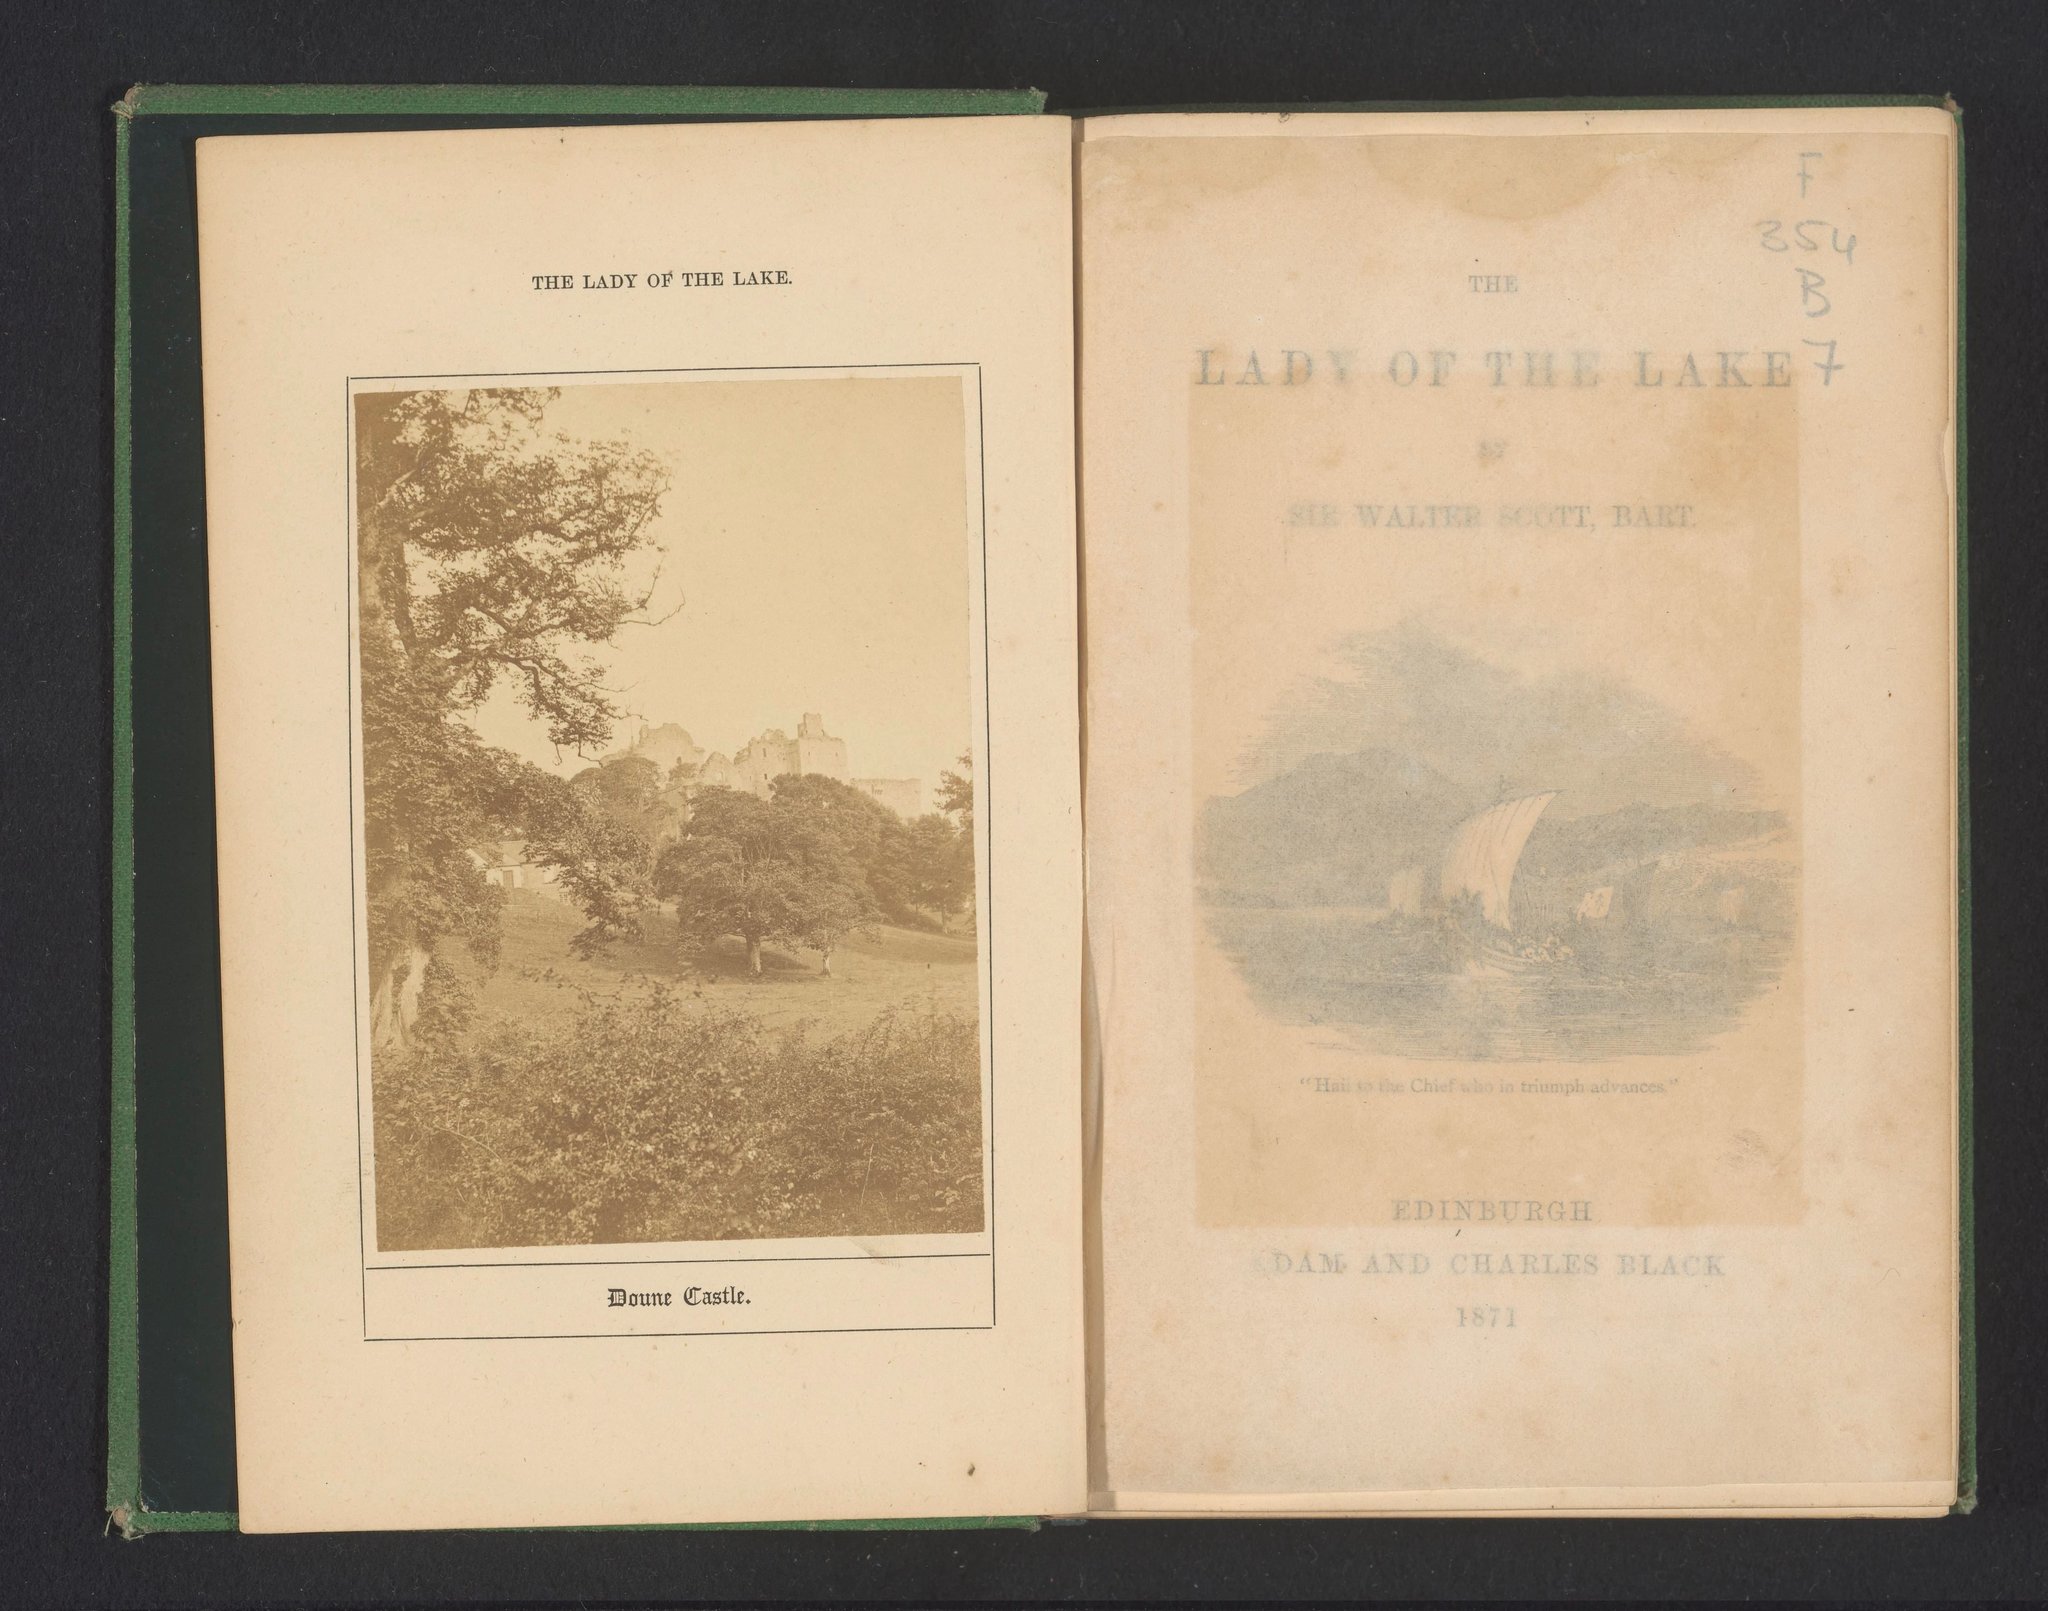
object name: photograph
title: Gezicht op Doune Castle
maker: george washington wilson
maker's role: publisher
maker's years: 1823-1893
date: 1861-1871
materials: photographic support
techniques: albumen print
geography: stirling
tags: castle